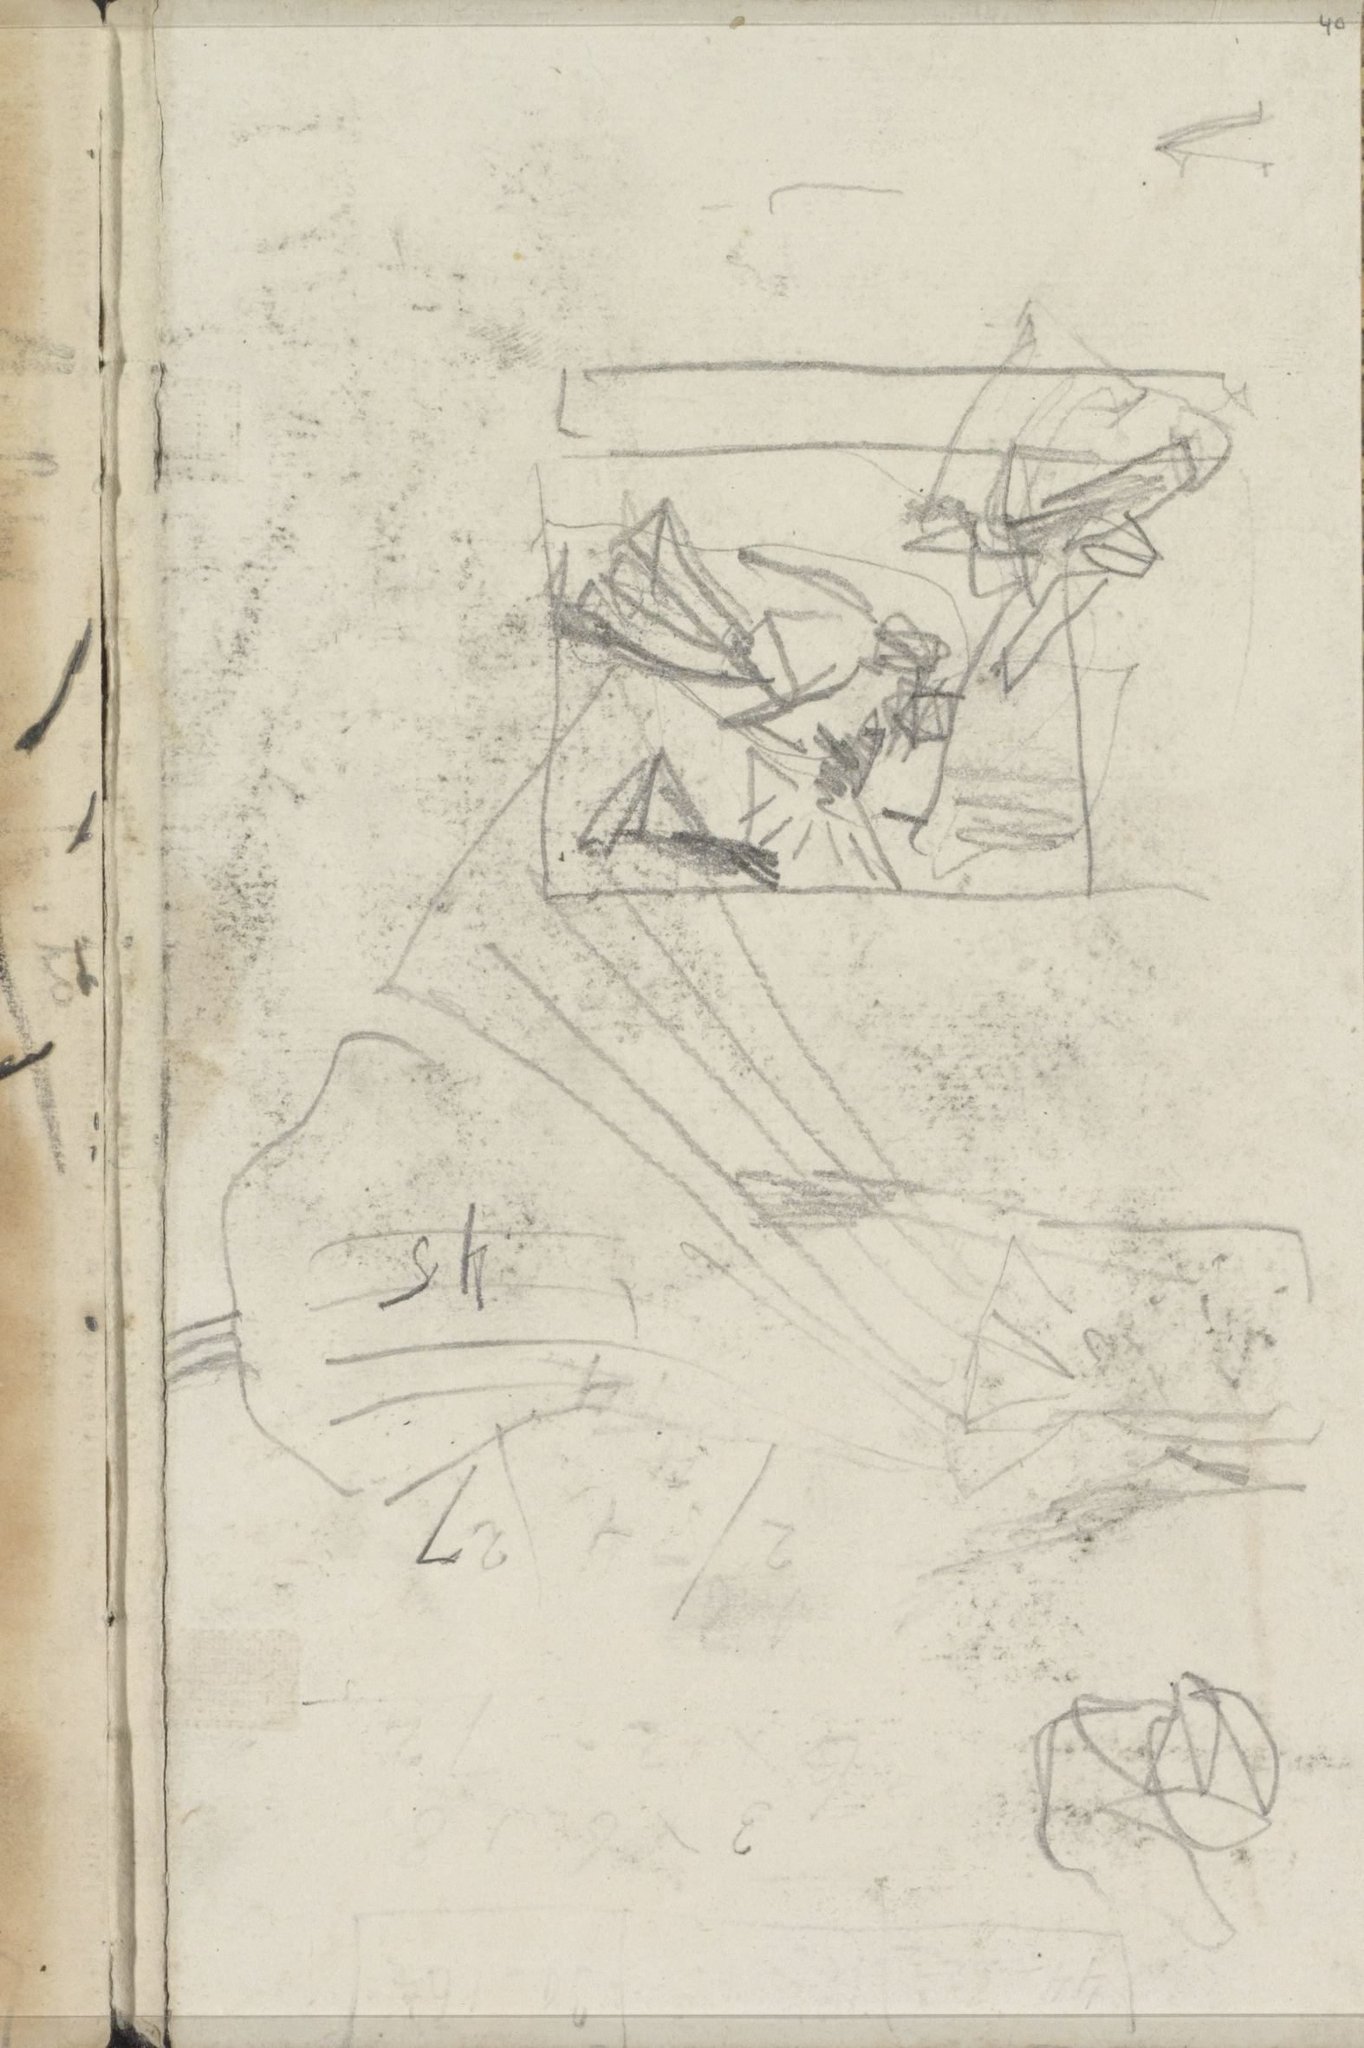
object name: endleaf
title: Figuurstudies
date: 1881-1883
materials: paper, pencil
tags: adult woman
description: Pagina 40, achterste schutblad, uit een schetsboek met 19 bladen.